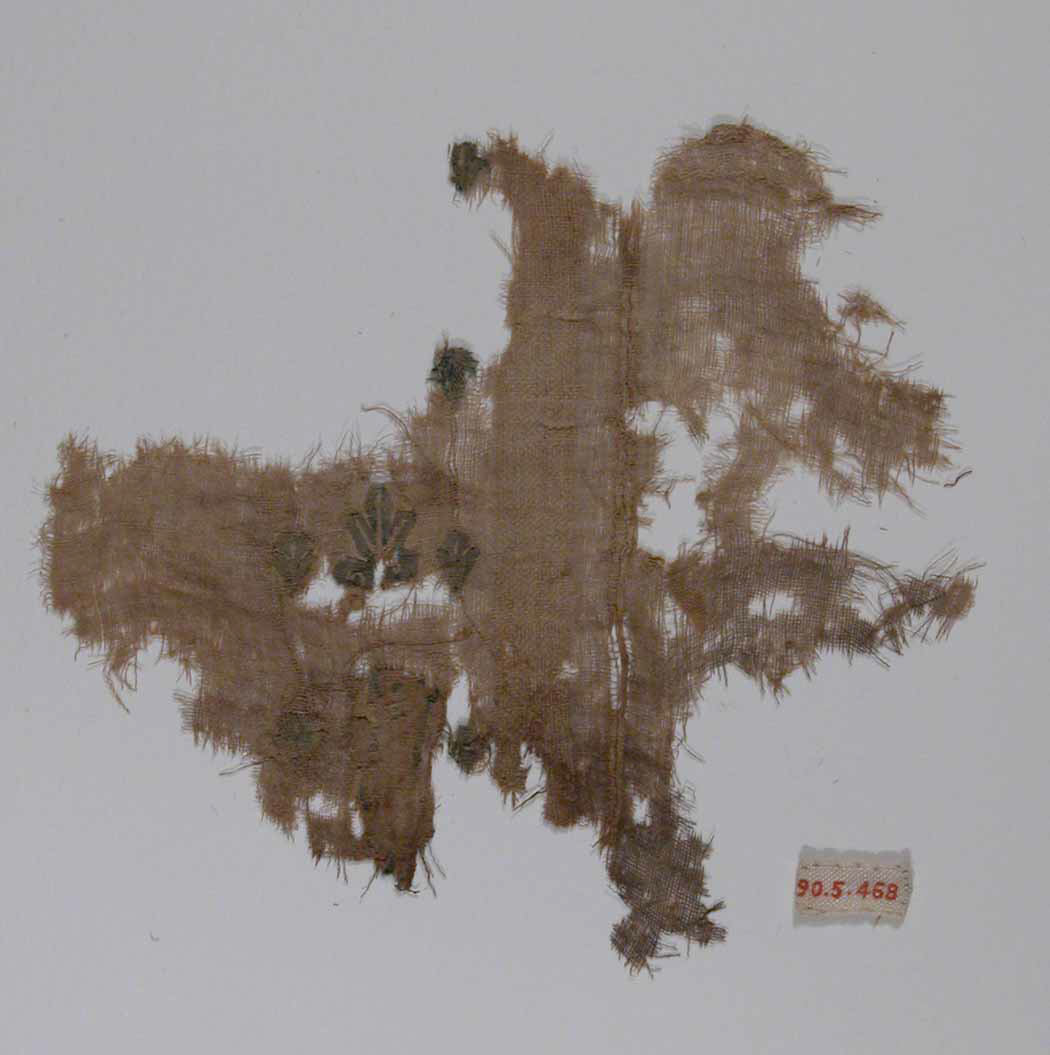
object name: textile fragment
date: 401-600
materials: linen, wool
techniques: weave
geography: egypt